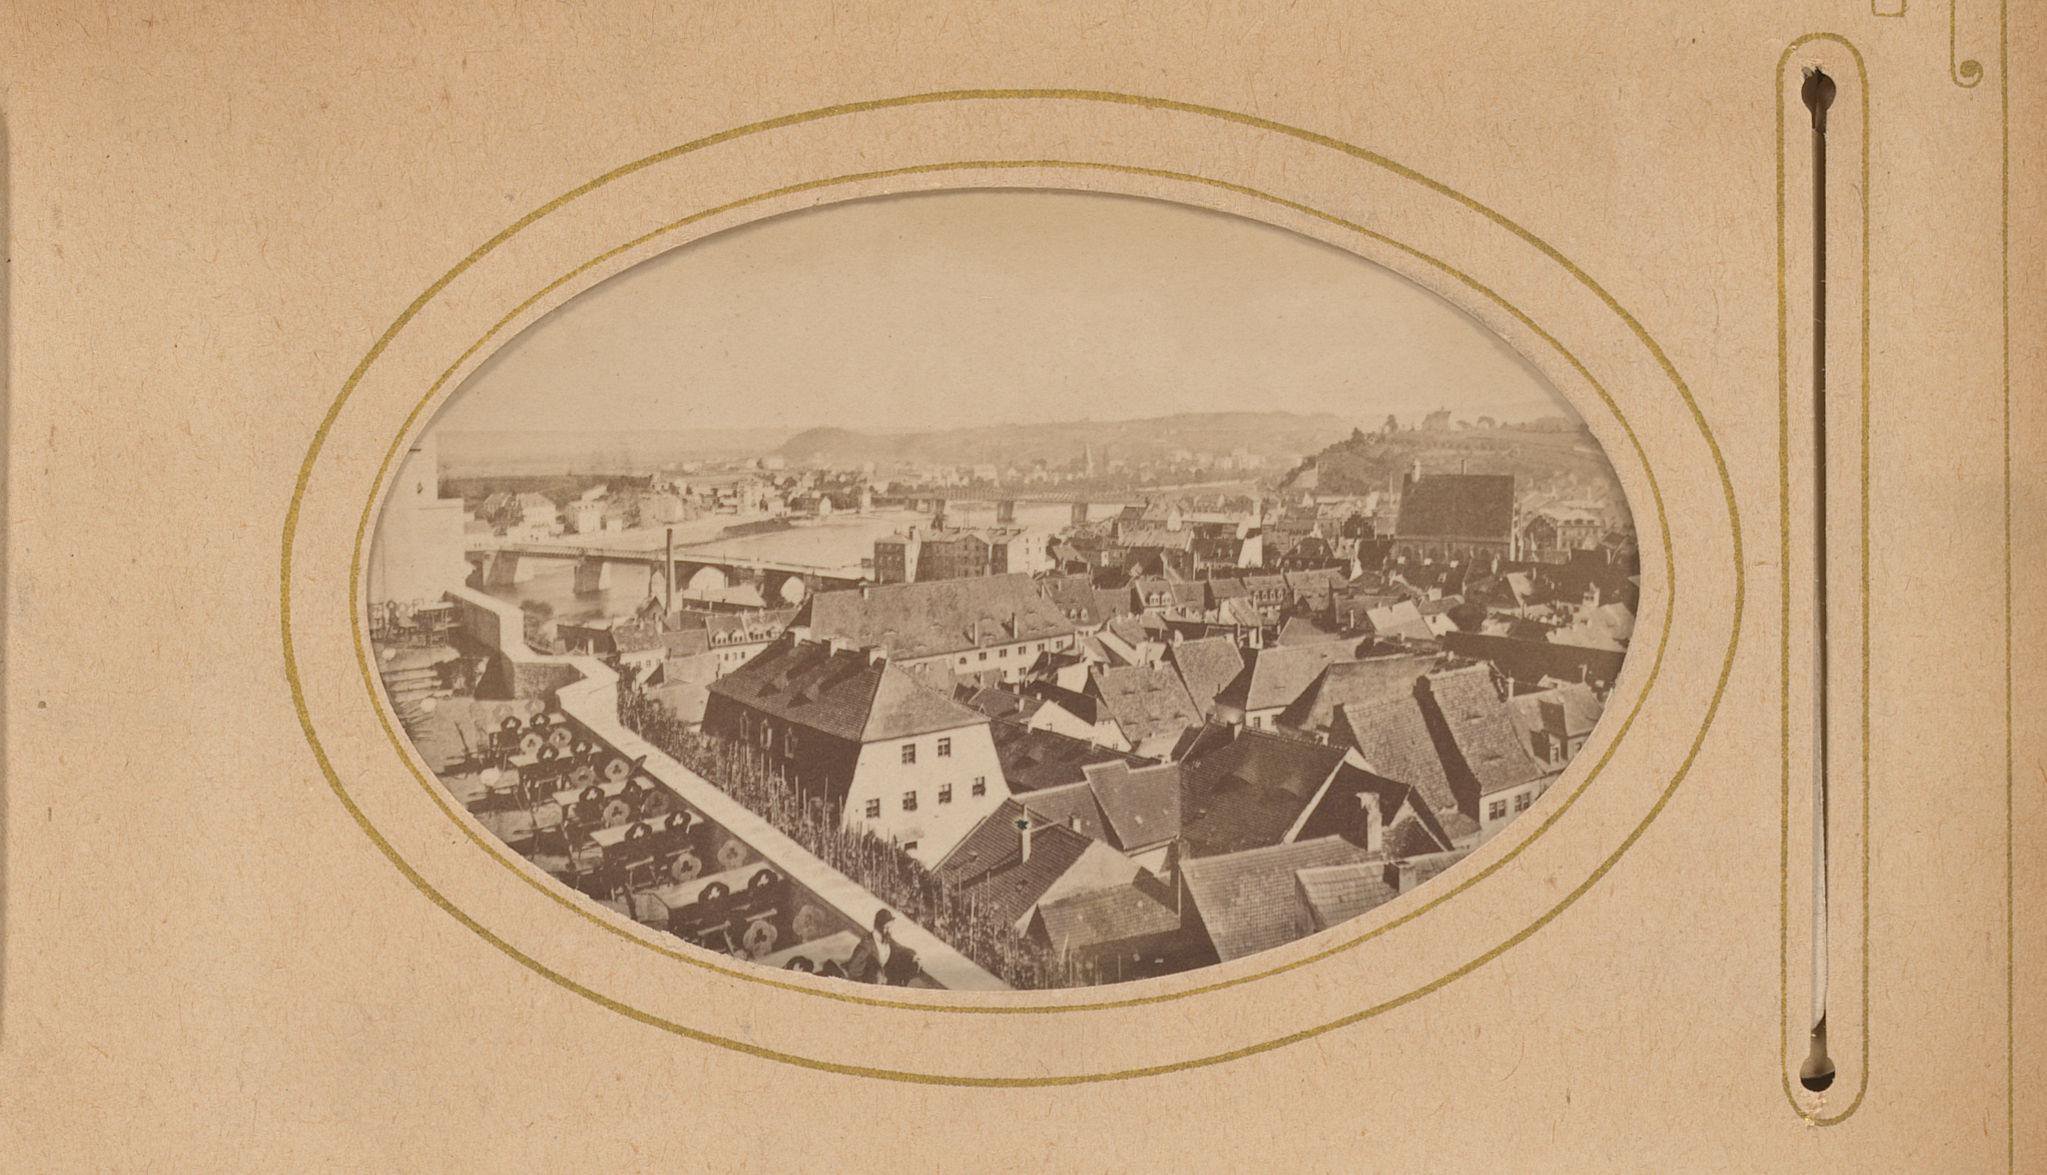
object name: album leaf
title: Stadsgezicht, vermoedelijk in Duitsland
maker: g. koczyk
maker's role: fotograaf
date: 1860-1900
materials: cardboard, photographic support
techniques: albumen print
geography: germany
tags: dale, valley, germany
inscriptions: inscription: ‘G. KOCZYK/ ATELIER/ für/ Portraits- und Landschafts-/ PHOTOGRAPHIE/ CHEMNITZ/ Zwingergasse No. 9./ MEISSEN/ Rothe Stufen No. 28./ Die Platte bleibt für Nachbestellungen/ sowie Vergösserungen aufbewahrt.’